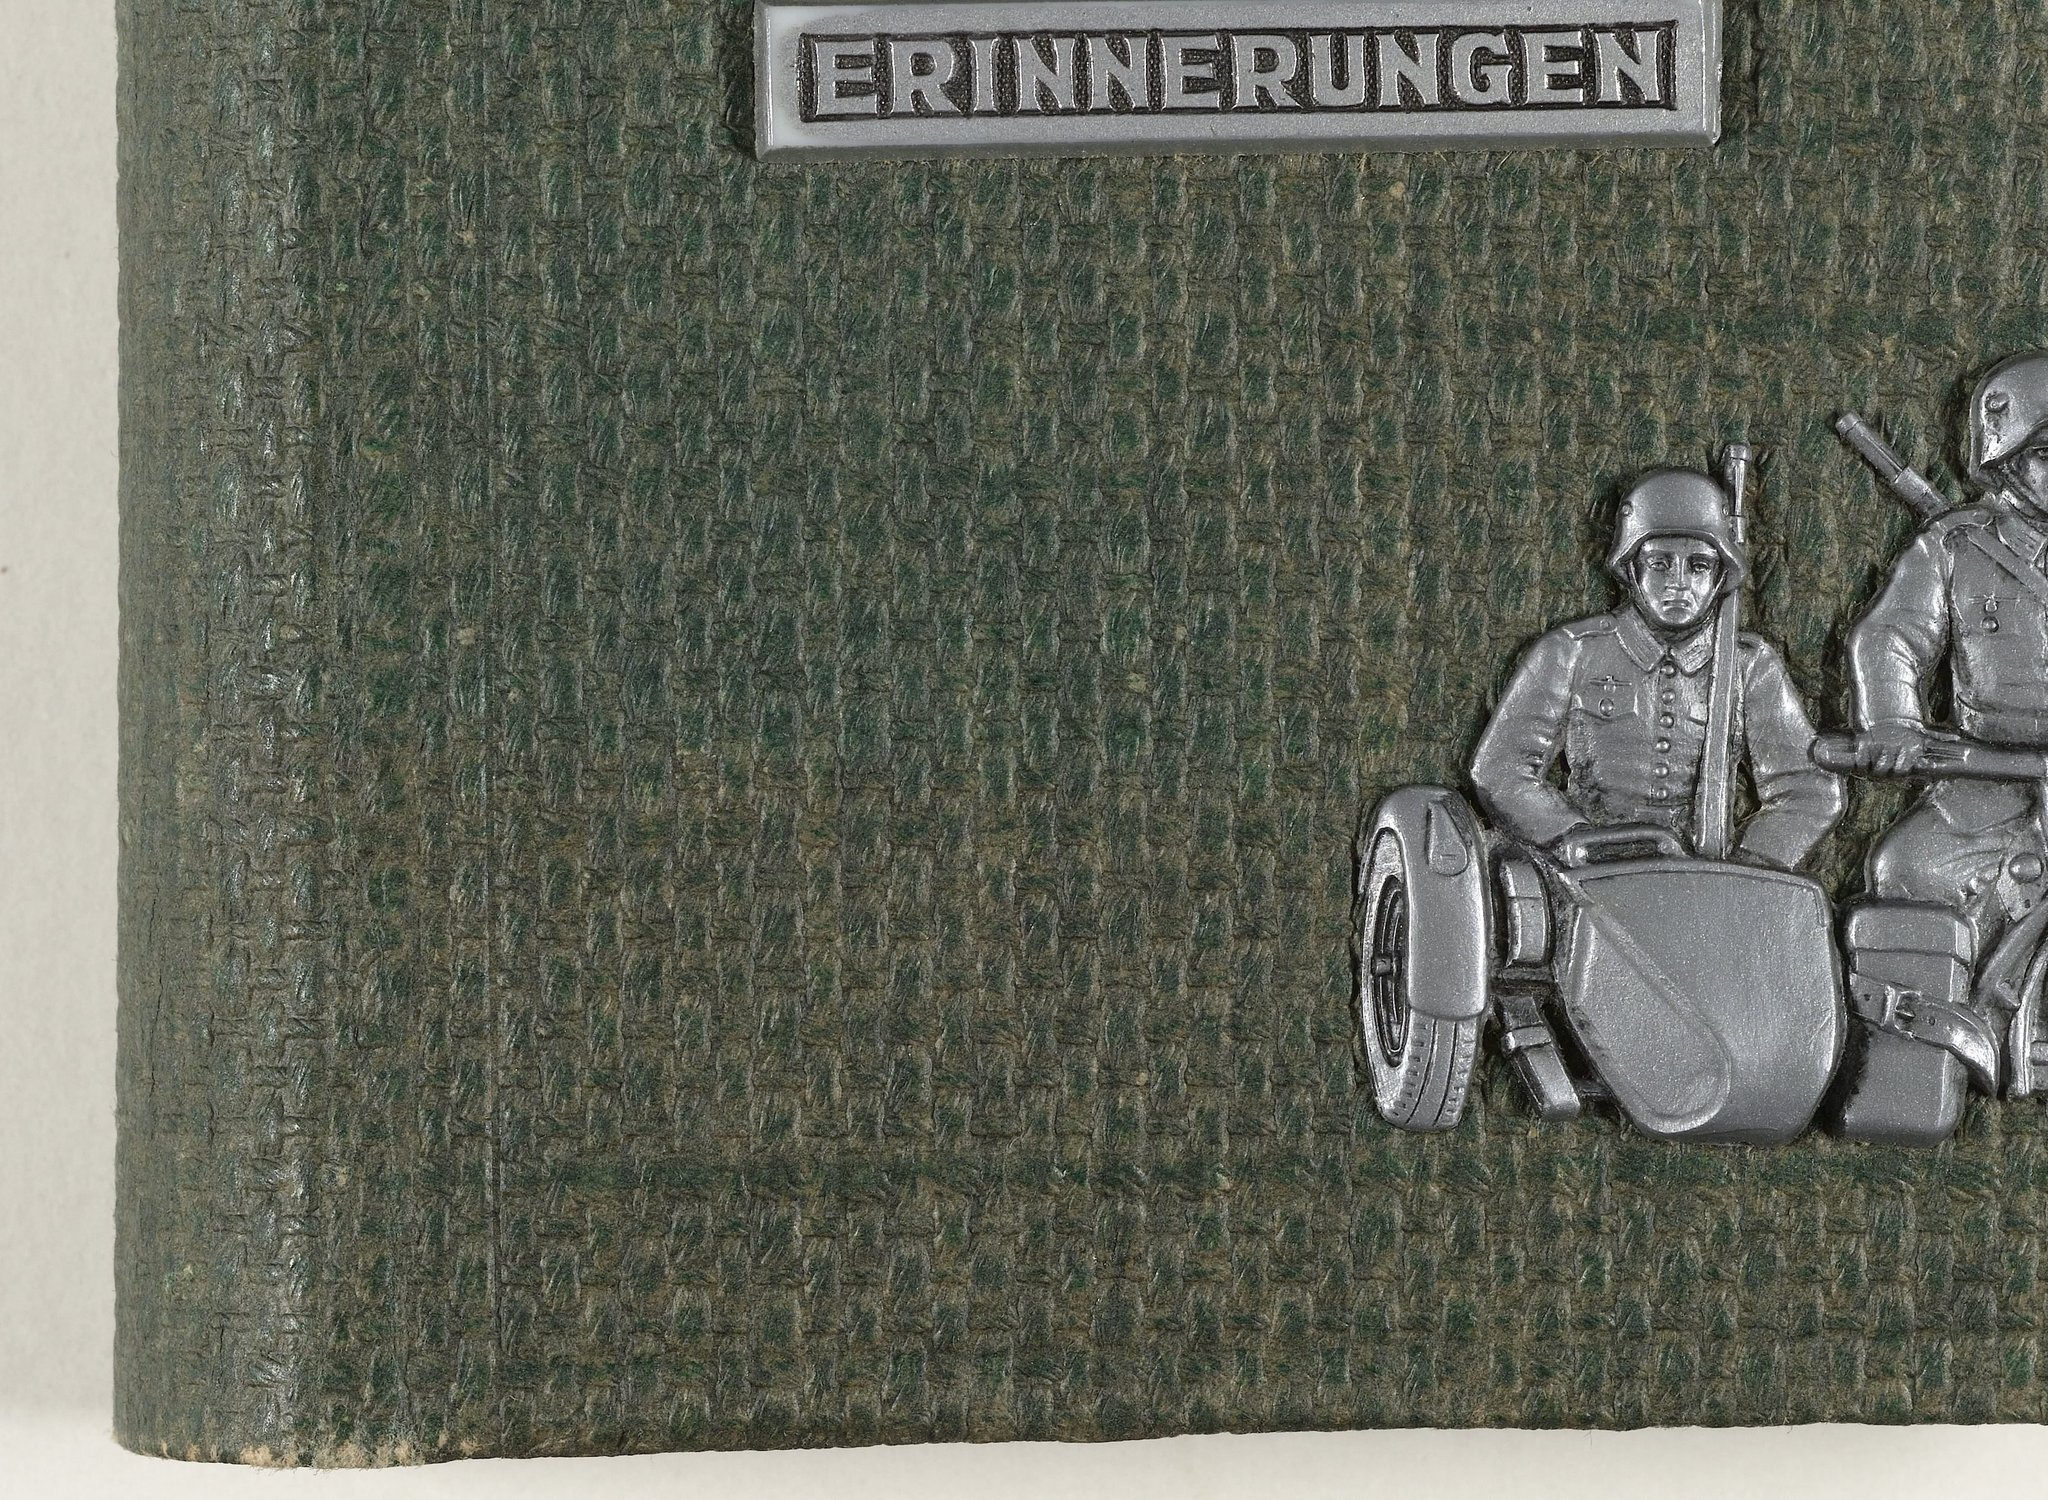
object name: photograph album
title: Erinnerungen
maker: Anonymous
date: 1939-1944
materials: cardboard, paper, plastic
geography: germany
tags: germany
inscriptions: inscription: ‘ERINNERUNGEN’, inscription: ‘Renate - Album / Nr. 5202 T’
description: Duits militair fotoalbum in kartonnen cassette zonder foto's. Op het omslag een opgeplakt kunststof opschrift 'Erinnerungen' en vignet van twee Duitse soldaten op motor met zijspan. Binnenwerk bestaat uit 26 bladzijden met een raamvenster voor 52 foto's. Op de rug van de cassette een etiket met opschrift: Renate-Album. Nr. 5202 T. Renate Album staat ook op een etiketje in het album. Geen foto's aanwezig.